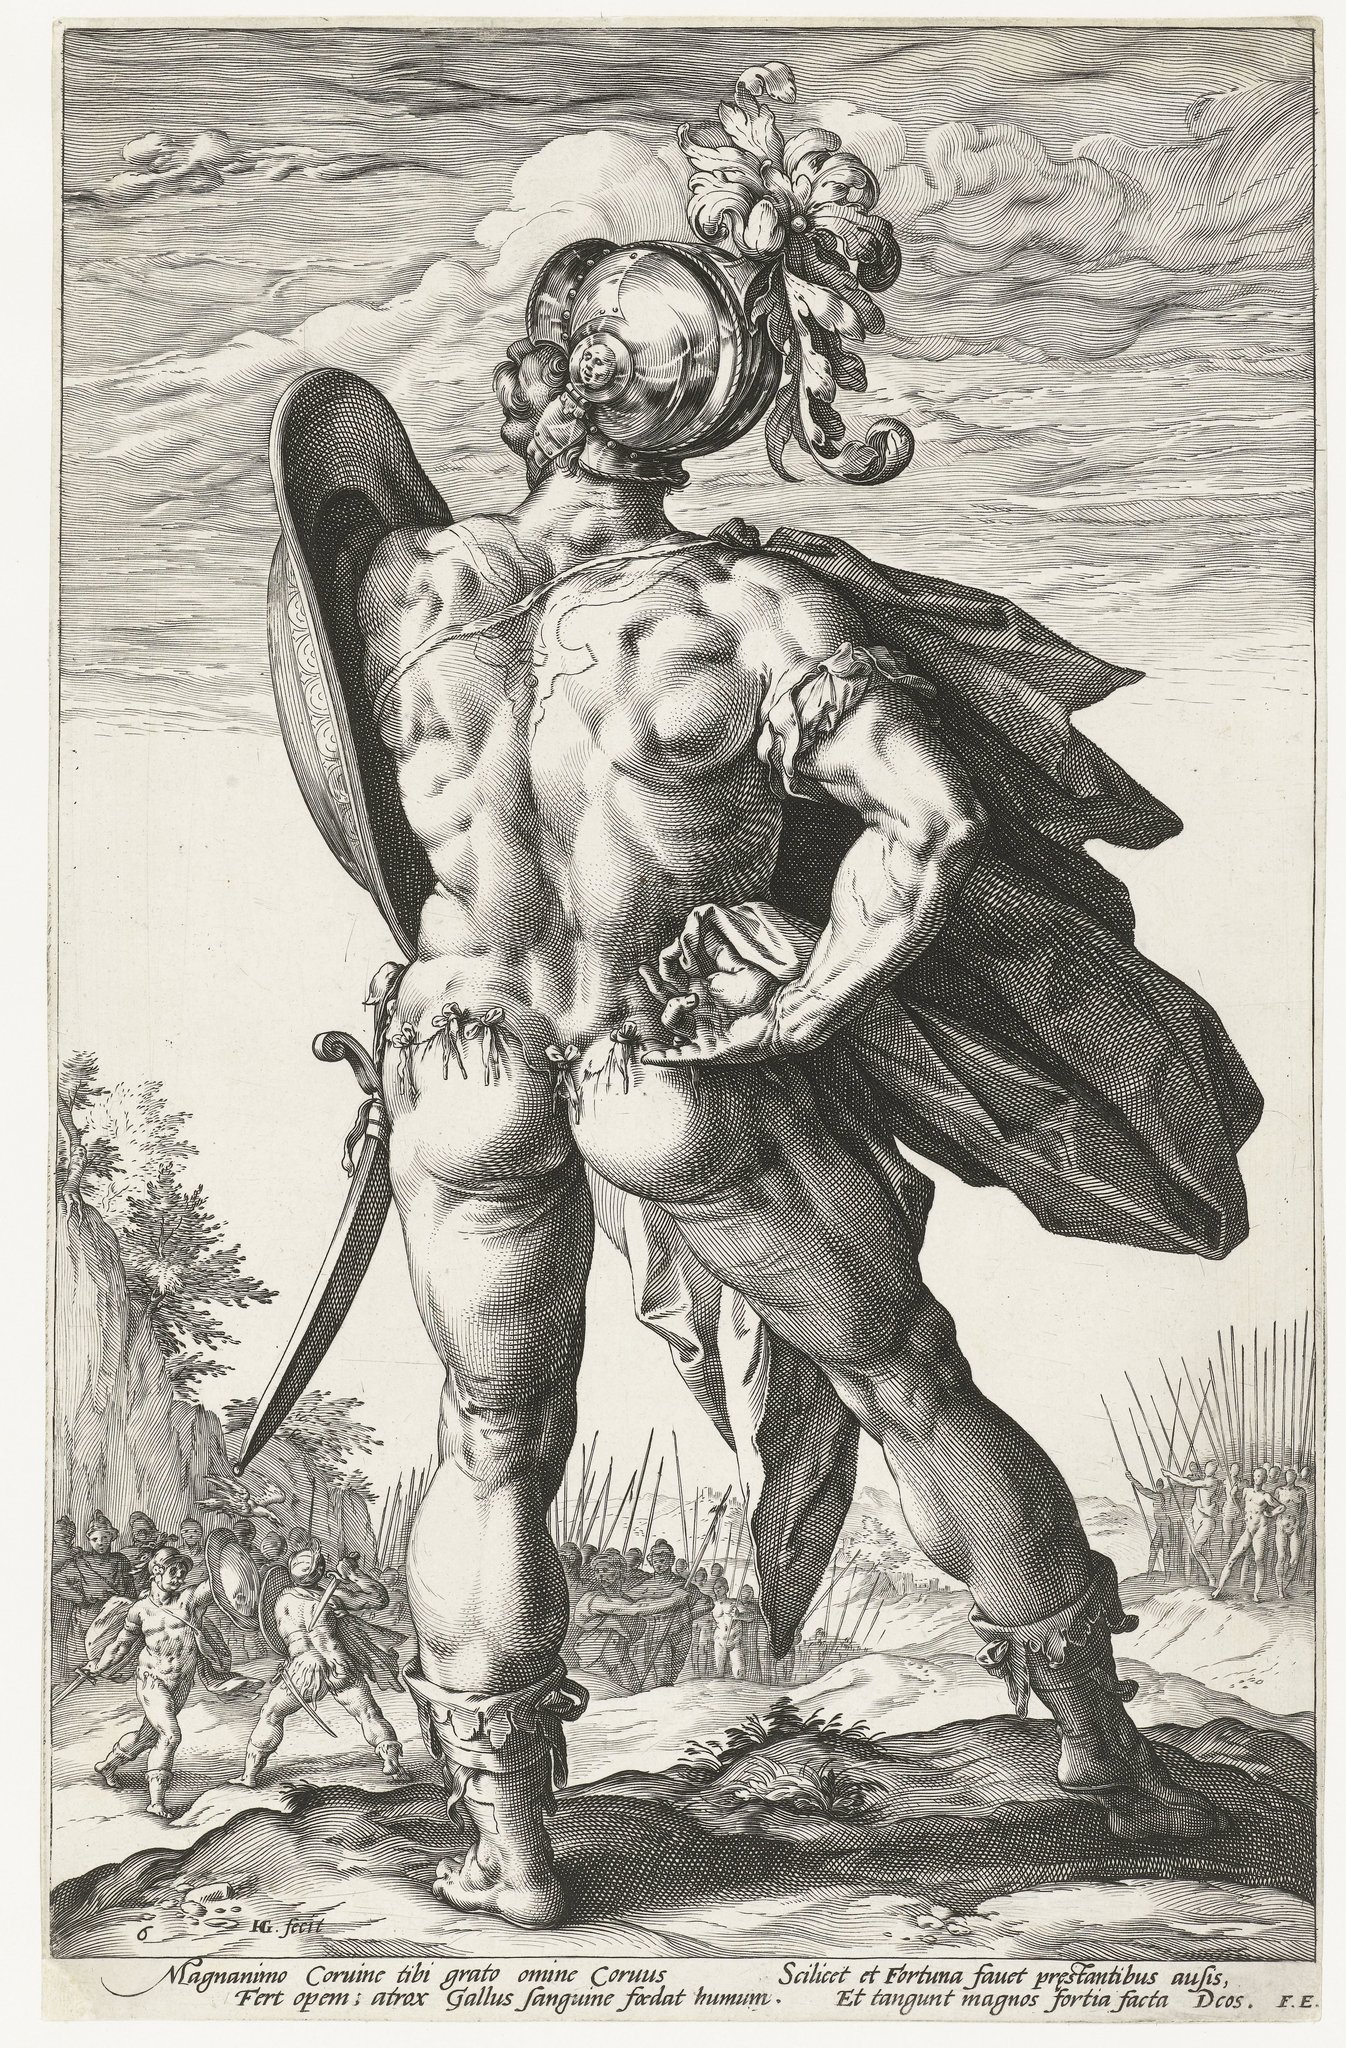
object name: print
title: Marcus Valerius Corvus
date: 1586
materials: paper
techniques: engraving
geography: haarlem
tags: marcus valerius corvus (corvinus) victoriously fights a mighty gaul in single combat, assisted by a crow that attacks the face of the gaul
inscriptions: caption: ‘Magnanimo Coruine...facta Deos.’, collector's mark: Lugt 240, signature: ‘HG. fecit’, number: ‘6’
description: De held Marcus Valerius Corvus ten voeten uit, op de rug gezien, zijn schild opgeheven bij zijn linkerschouder. Op de achtergrond is te zien hoe hij met de hulp van een raaf (corvus) een Galliër verslaat. Onder de voorstelling twee maal twee versregels in Latijn. Deze prent is onderdeel van een serie van tien prenten, bestaand uit een ongenummerde titelprent, acht genummerde voorstellingen van helden en een ongenummerde afsluitende prent.